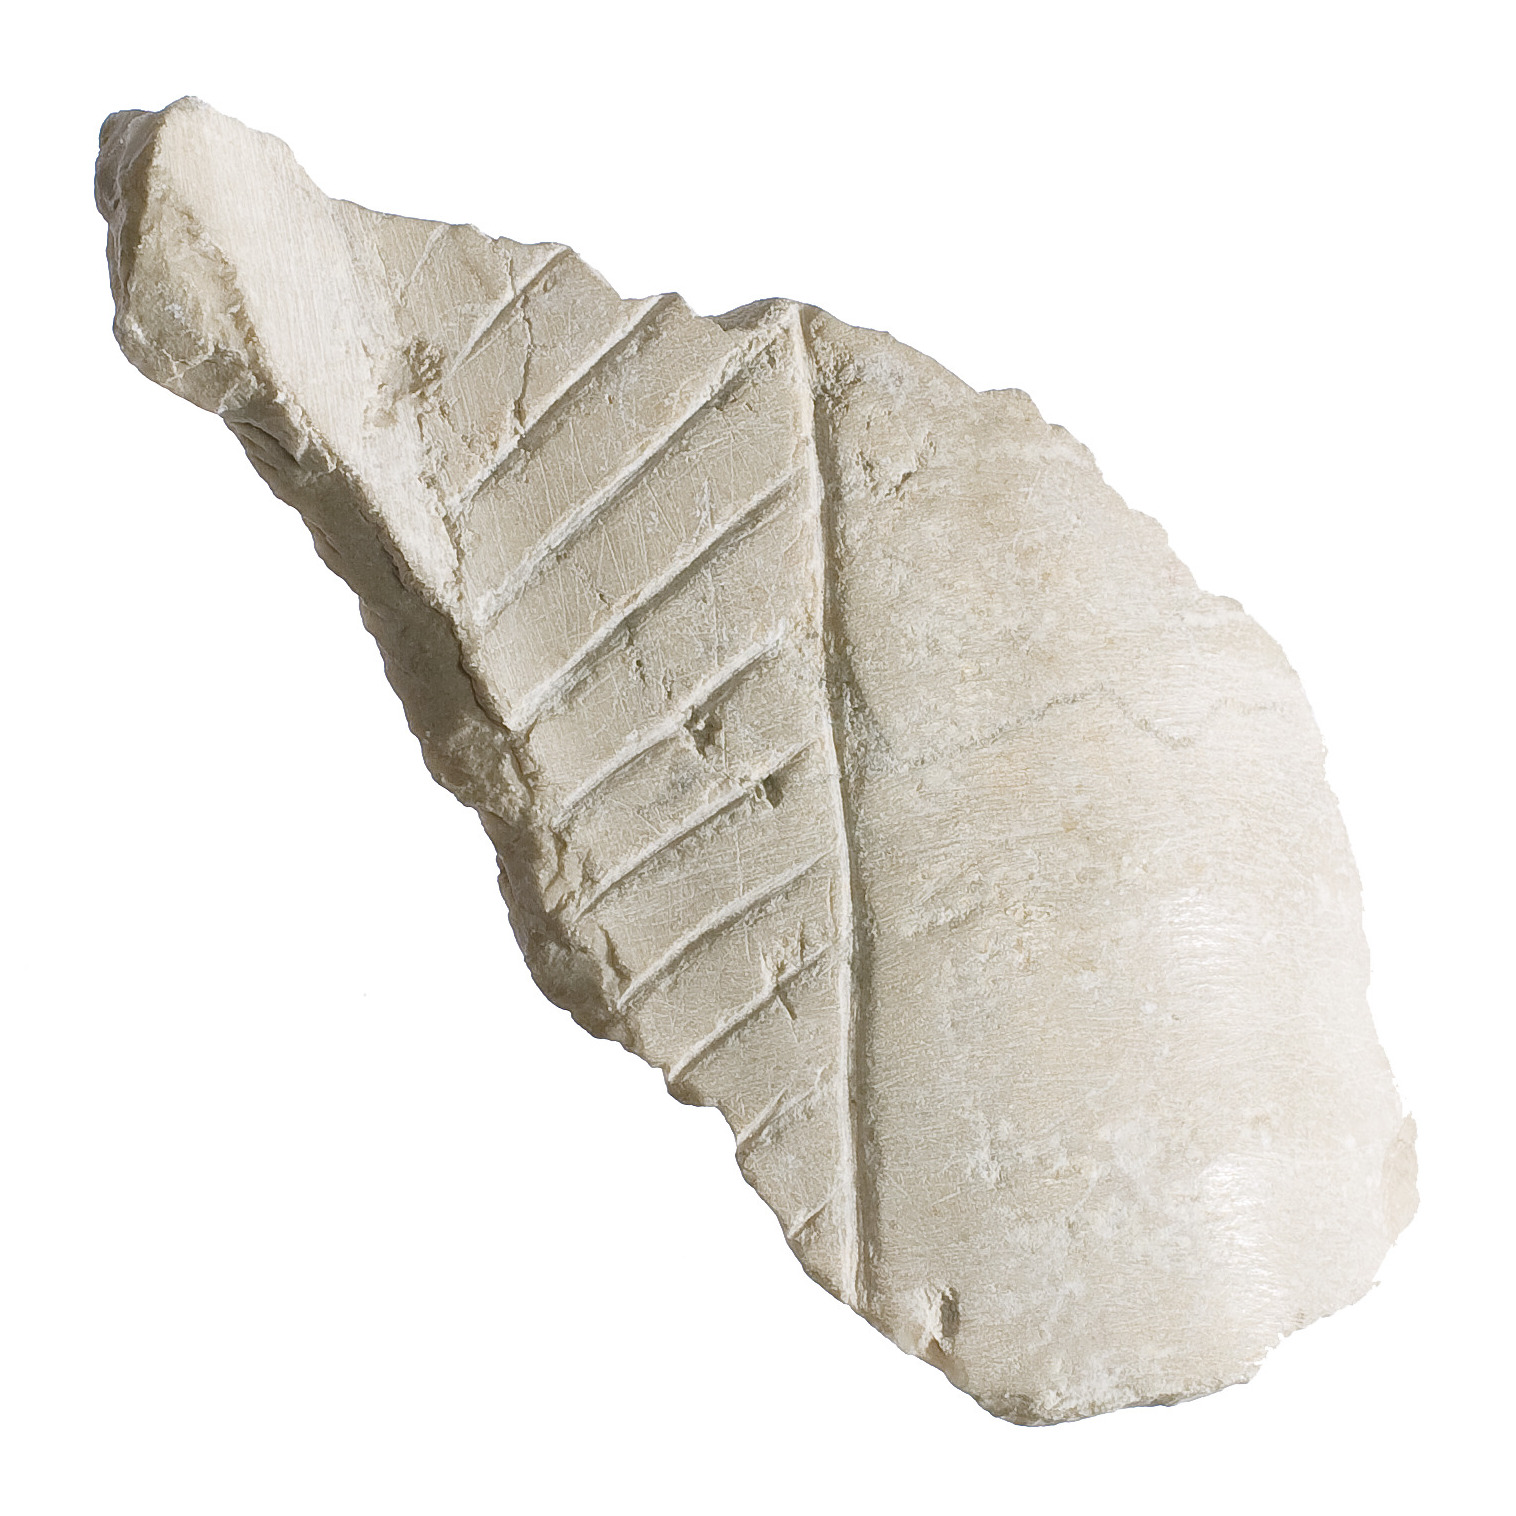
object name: limb with garment, pleating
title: Limb with garment fringe, pleating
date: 1353-1336 BCE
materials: limestone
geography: egypt